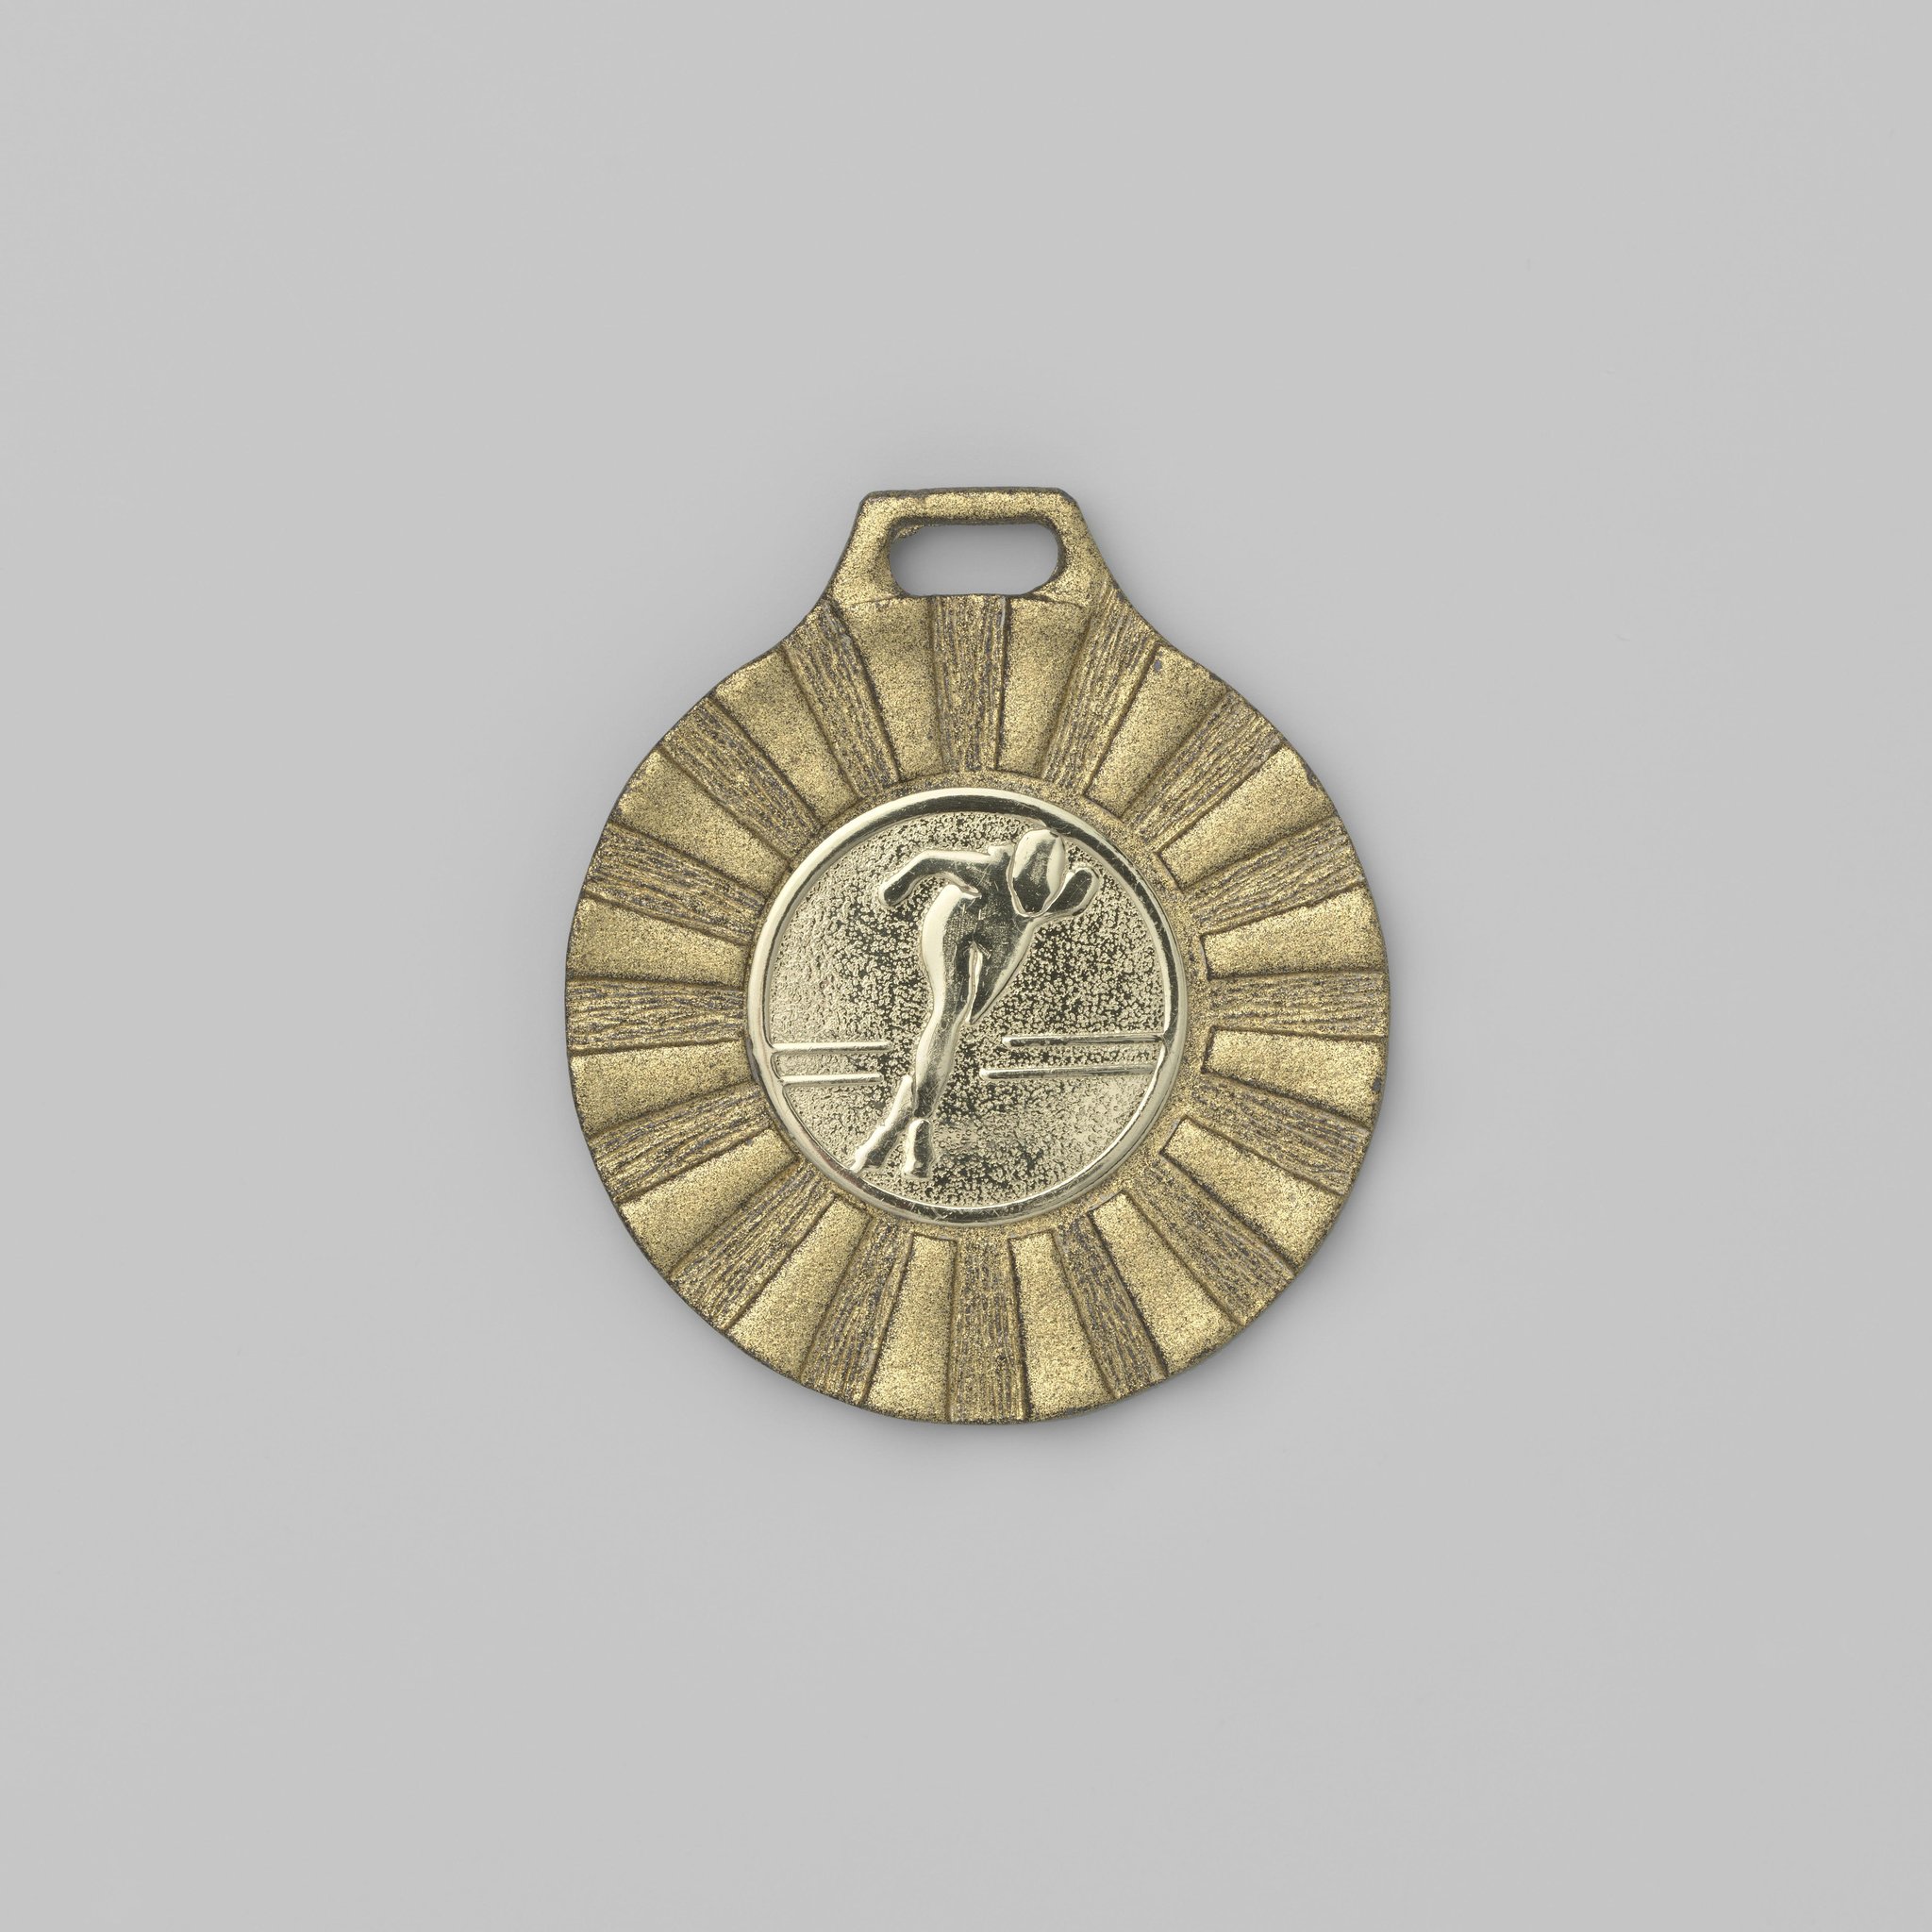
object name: onderscheidingsteken, onderscheiding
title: Onderscheiding Slotermeertoertocht 1991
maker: Anonymous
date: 1991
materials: metal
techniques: striking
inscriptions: inscription: ‘Slotermeertoertocht 6-2-1991’